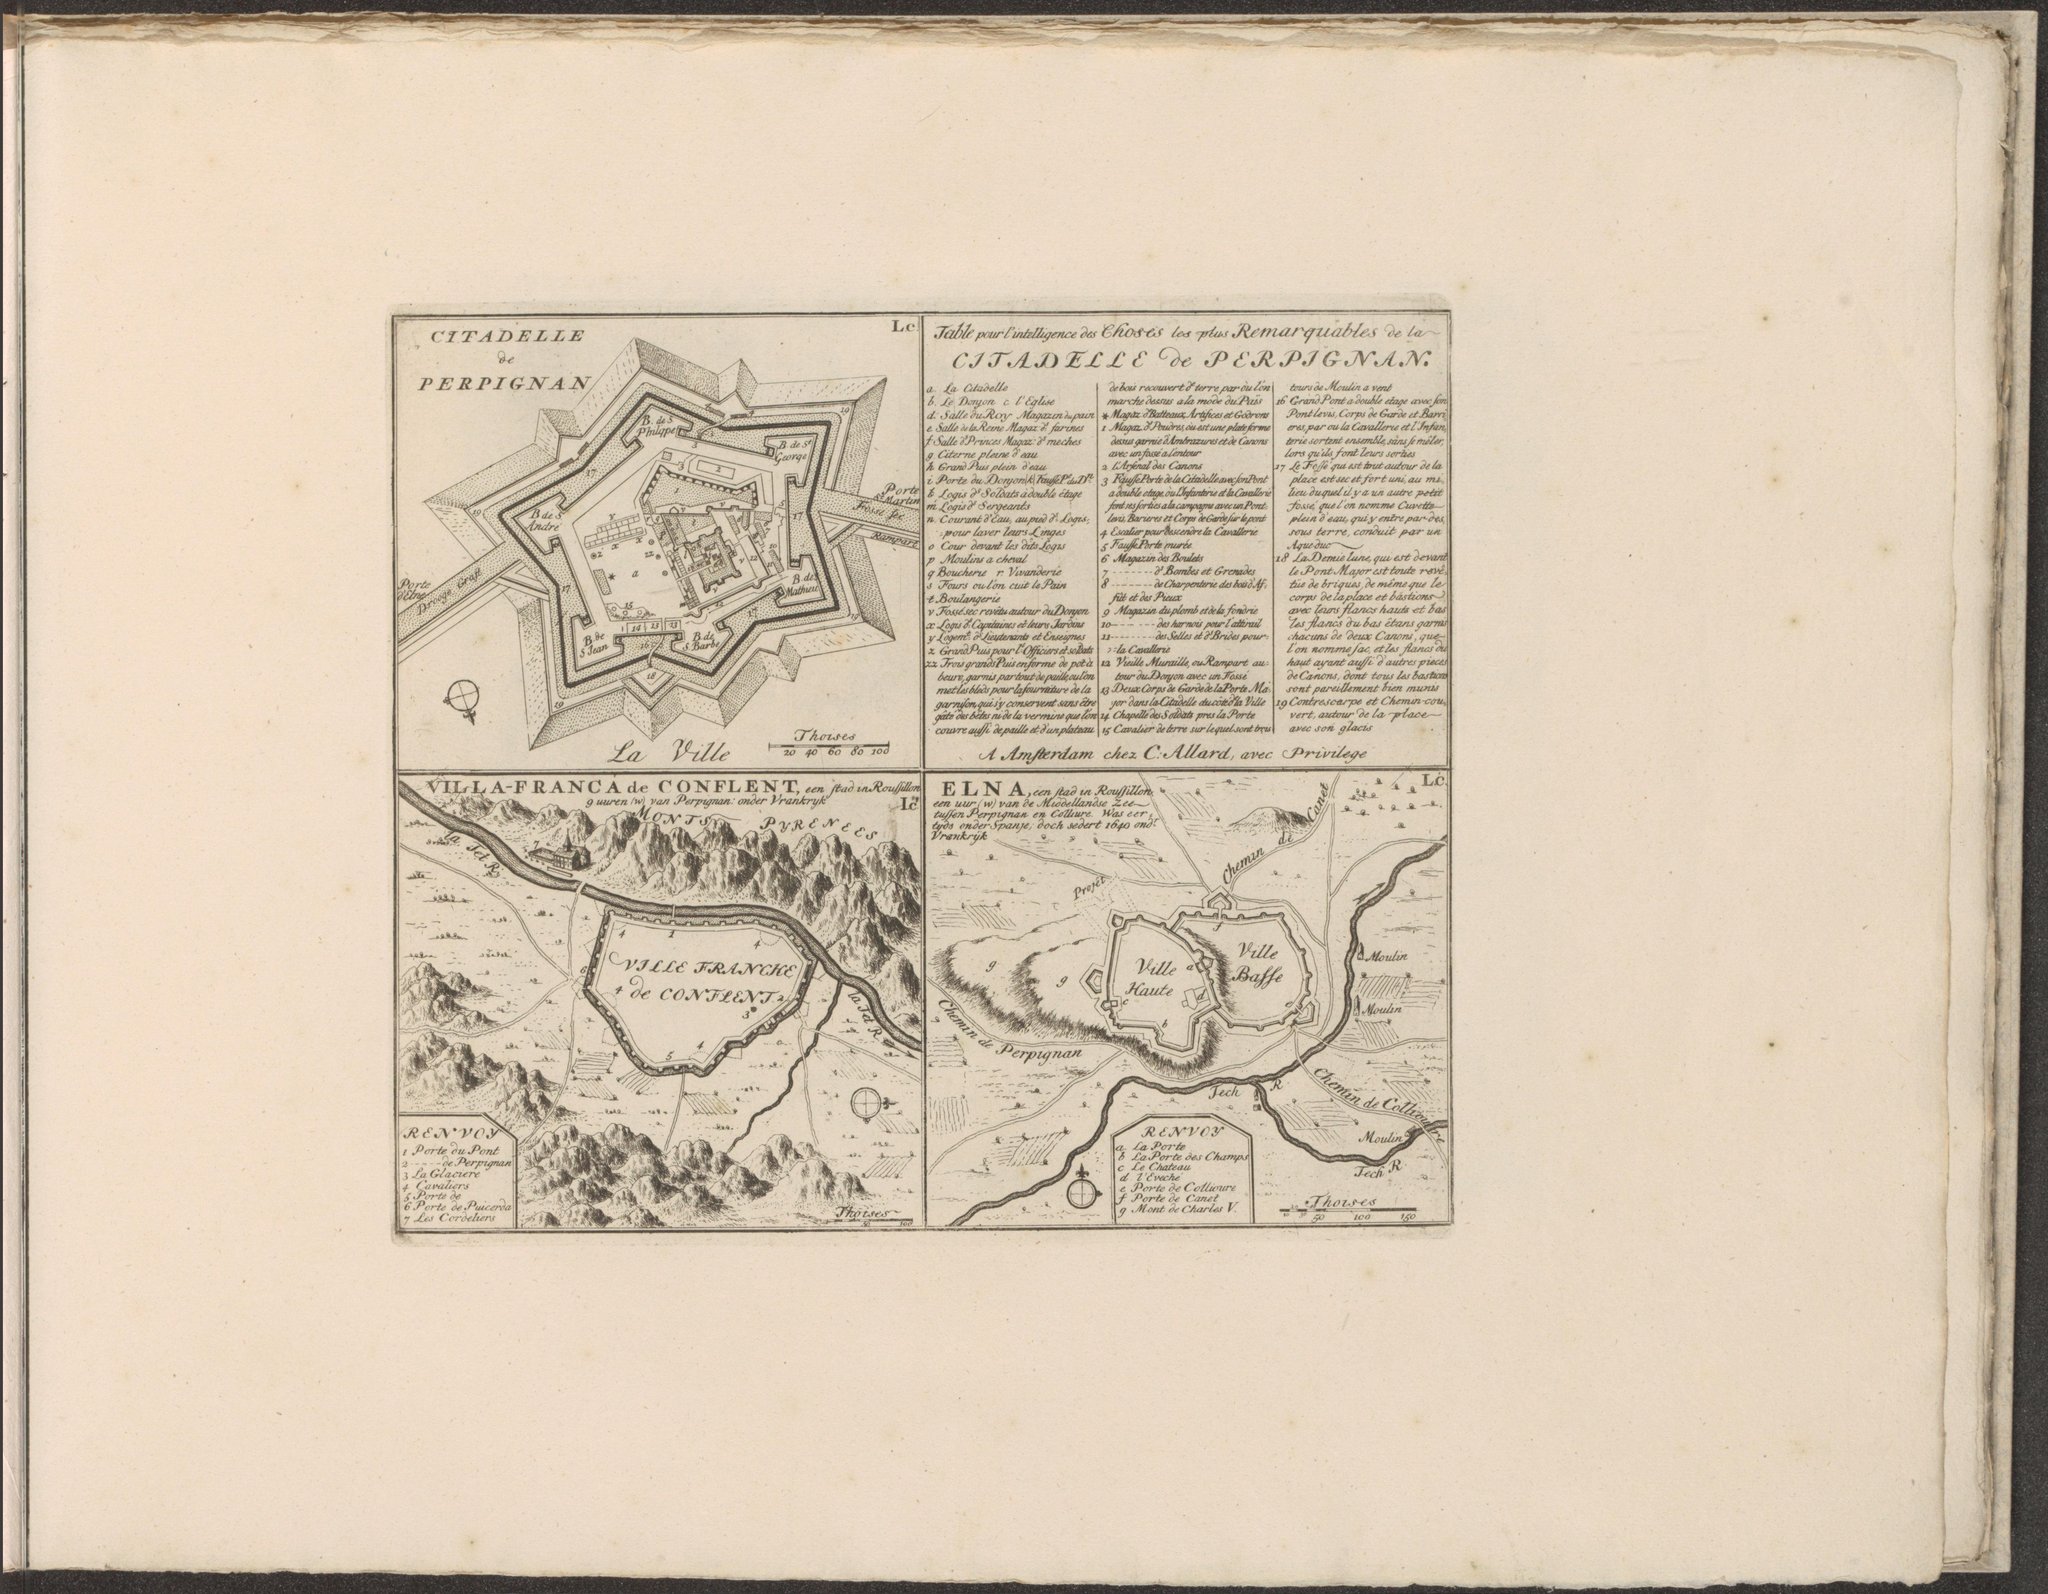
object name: album leaf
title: Perpignan en andere steden in Rousillon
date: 1701-1733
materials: paper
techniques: etching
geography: amsterdam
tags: fortifications, military engineering, maps of cities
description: De vesting van Perpignan met legenda. Daaronder twee andere plaatsen in Rousillon. Met teksten in het Nederlands en Frans. De prent maakt deel uit van een album.